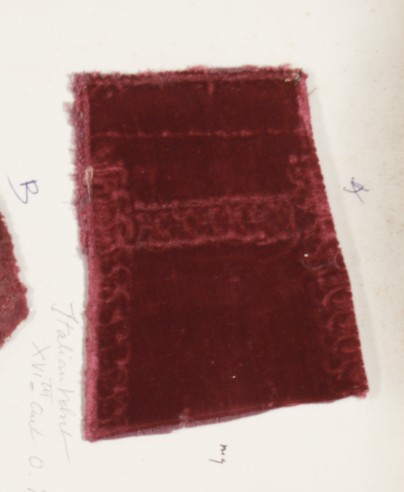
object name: fragment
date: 1501-1600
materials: silk